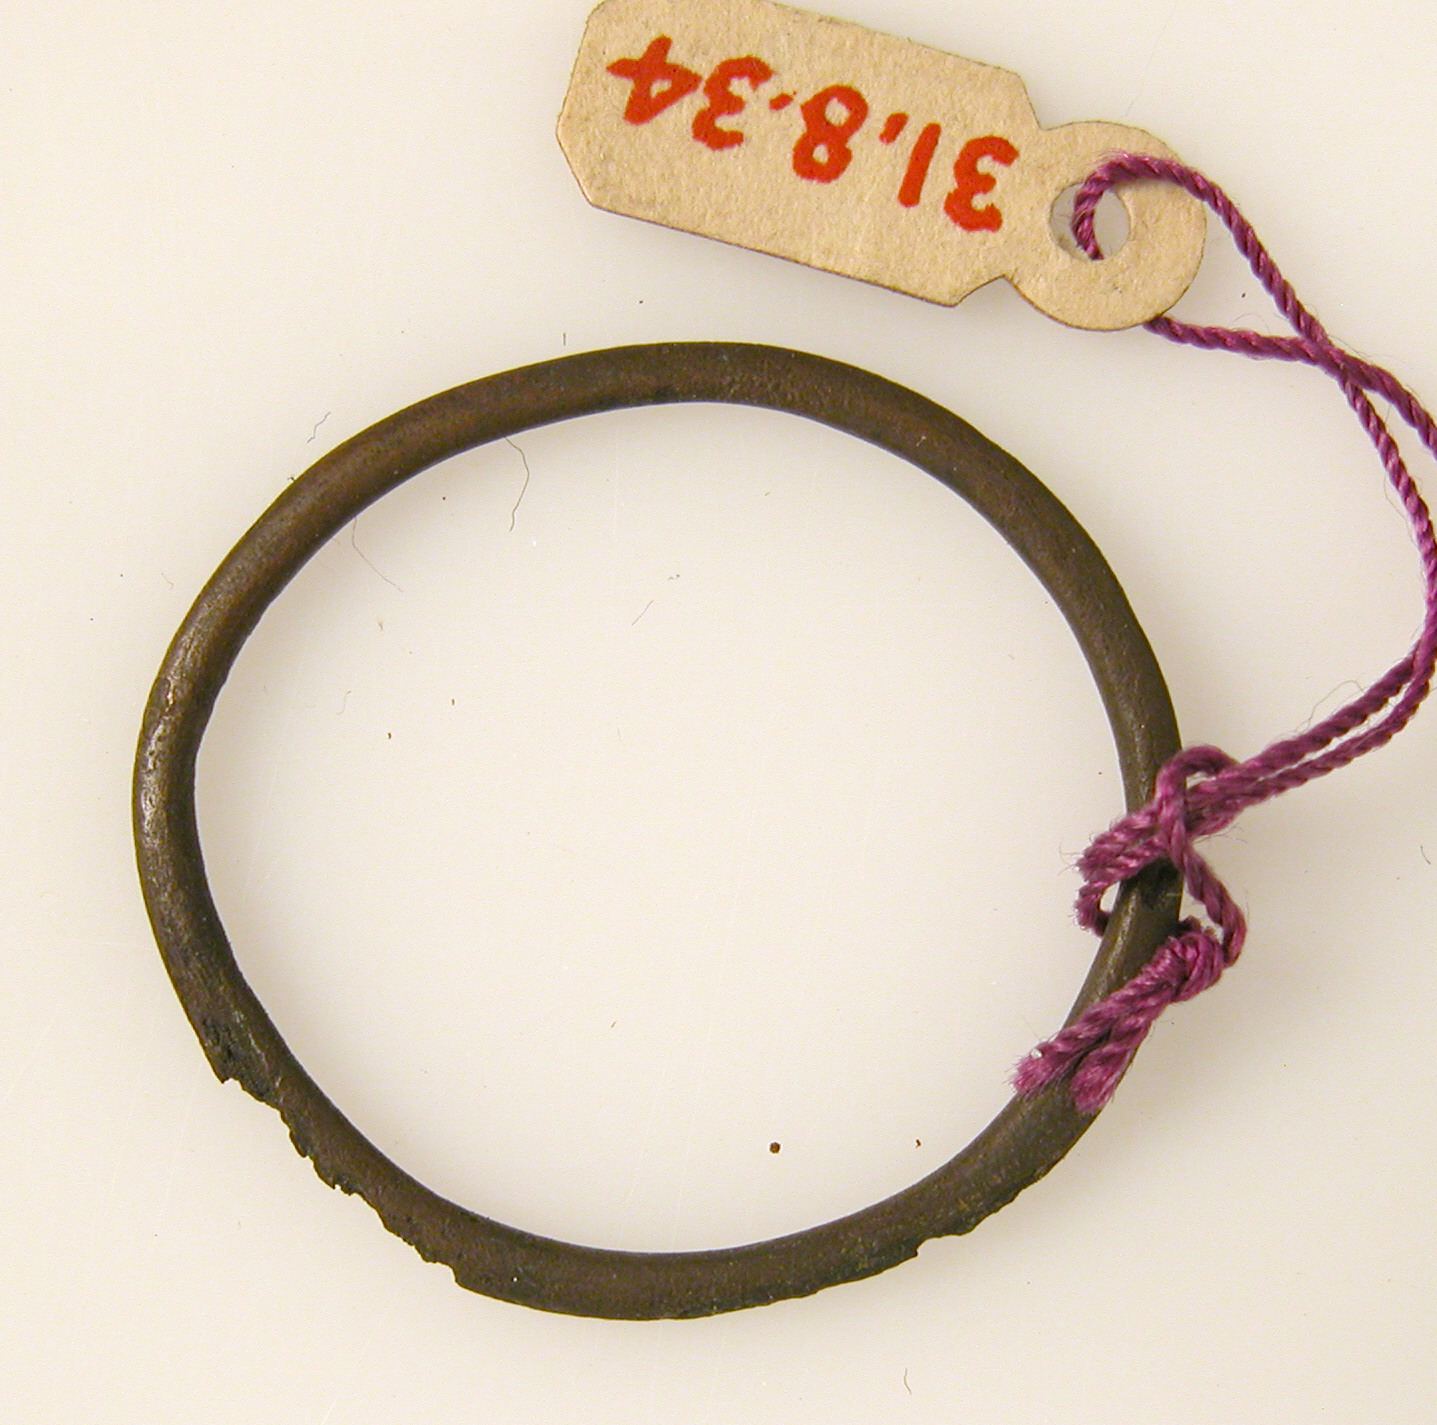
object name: ring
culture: coptic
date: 301-400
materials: copper alloy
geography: egypt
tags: rings